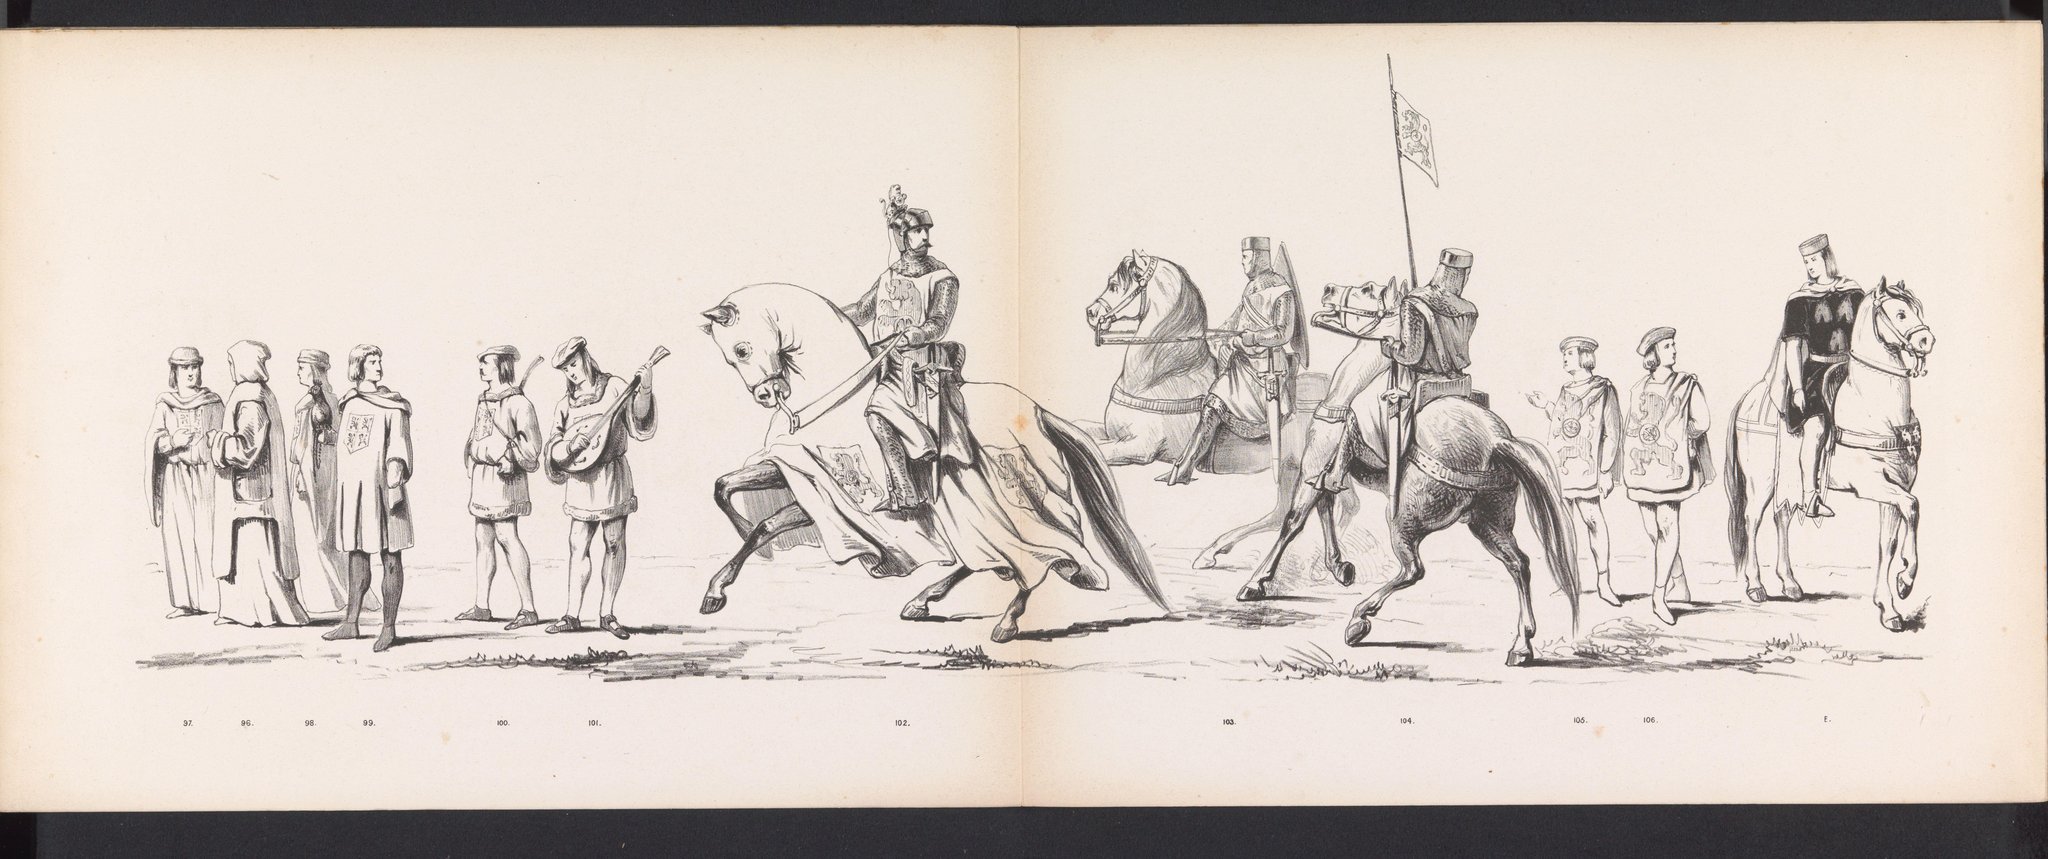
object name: print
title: Gecostumeerde optogt gehouden door de leden van het Leidsche studenten-corps den 6den Junij 1865, ter viering van den 290sten verjaardag der Leidsche Hoogeschool, voorstellende: de intogt der Hollanders binnen Zierikzee onder Jonker Willem, Grave van Oostervant, op den 12den augustus Anno 1304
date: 1865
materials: paper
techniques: lithograph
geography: netherlands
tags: students' pageant, costumes used in pageants, leiden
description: Historische gekostumeerde optocht van de studenten van de Leidse Hogeschool gehouden op 6 juni 1865 ter gelegenheid van het 290-jarig bestaan van de Hogeschool. De optocht verbeeldt de intocht van de Hollanders binnen Zierikzee op 12 augustus 1304. Achtste plaat met de groepen genummerd 97-106. Onderdeel van de serie van 16 aaneen geplakte bladen.